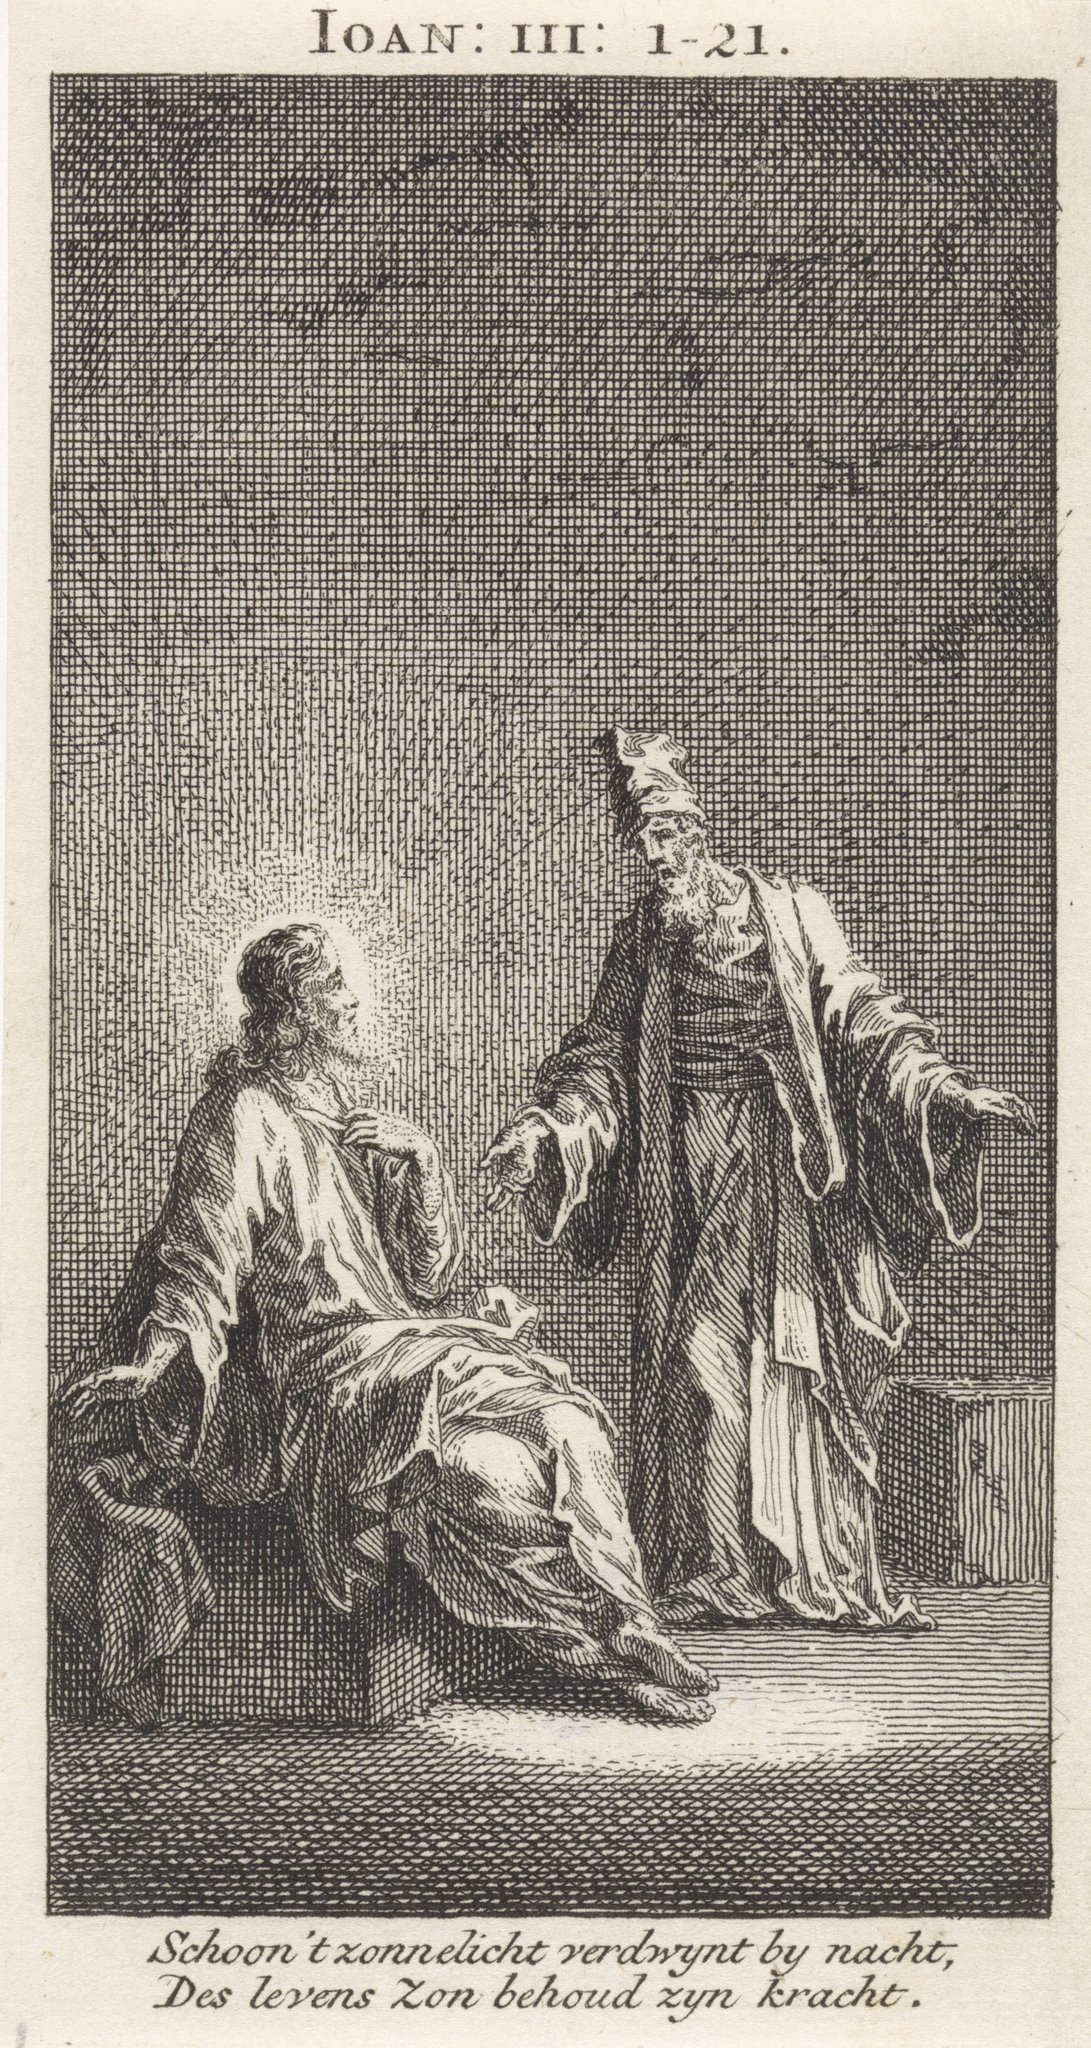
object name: print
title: Gesprek tussen Christus en Nikodemus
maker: Anonymous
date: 1712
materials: paper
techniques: etching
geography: amsterdam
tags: christ talking with nicodemus at night (john 3:1-21)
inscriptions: collector's mark: Lugt 2228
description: Kopie van illustratie voor: Luyken, Jan. Bybel printen. Amsterdam: Pieter Arentsz. II (wed.) en Cornelis van der Sys, 1712, p. 31.